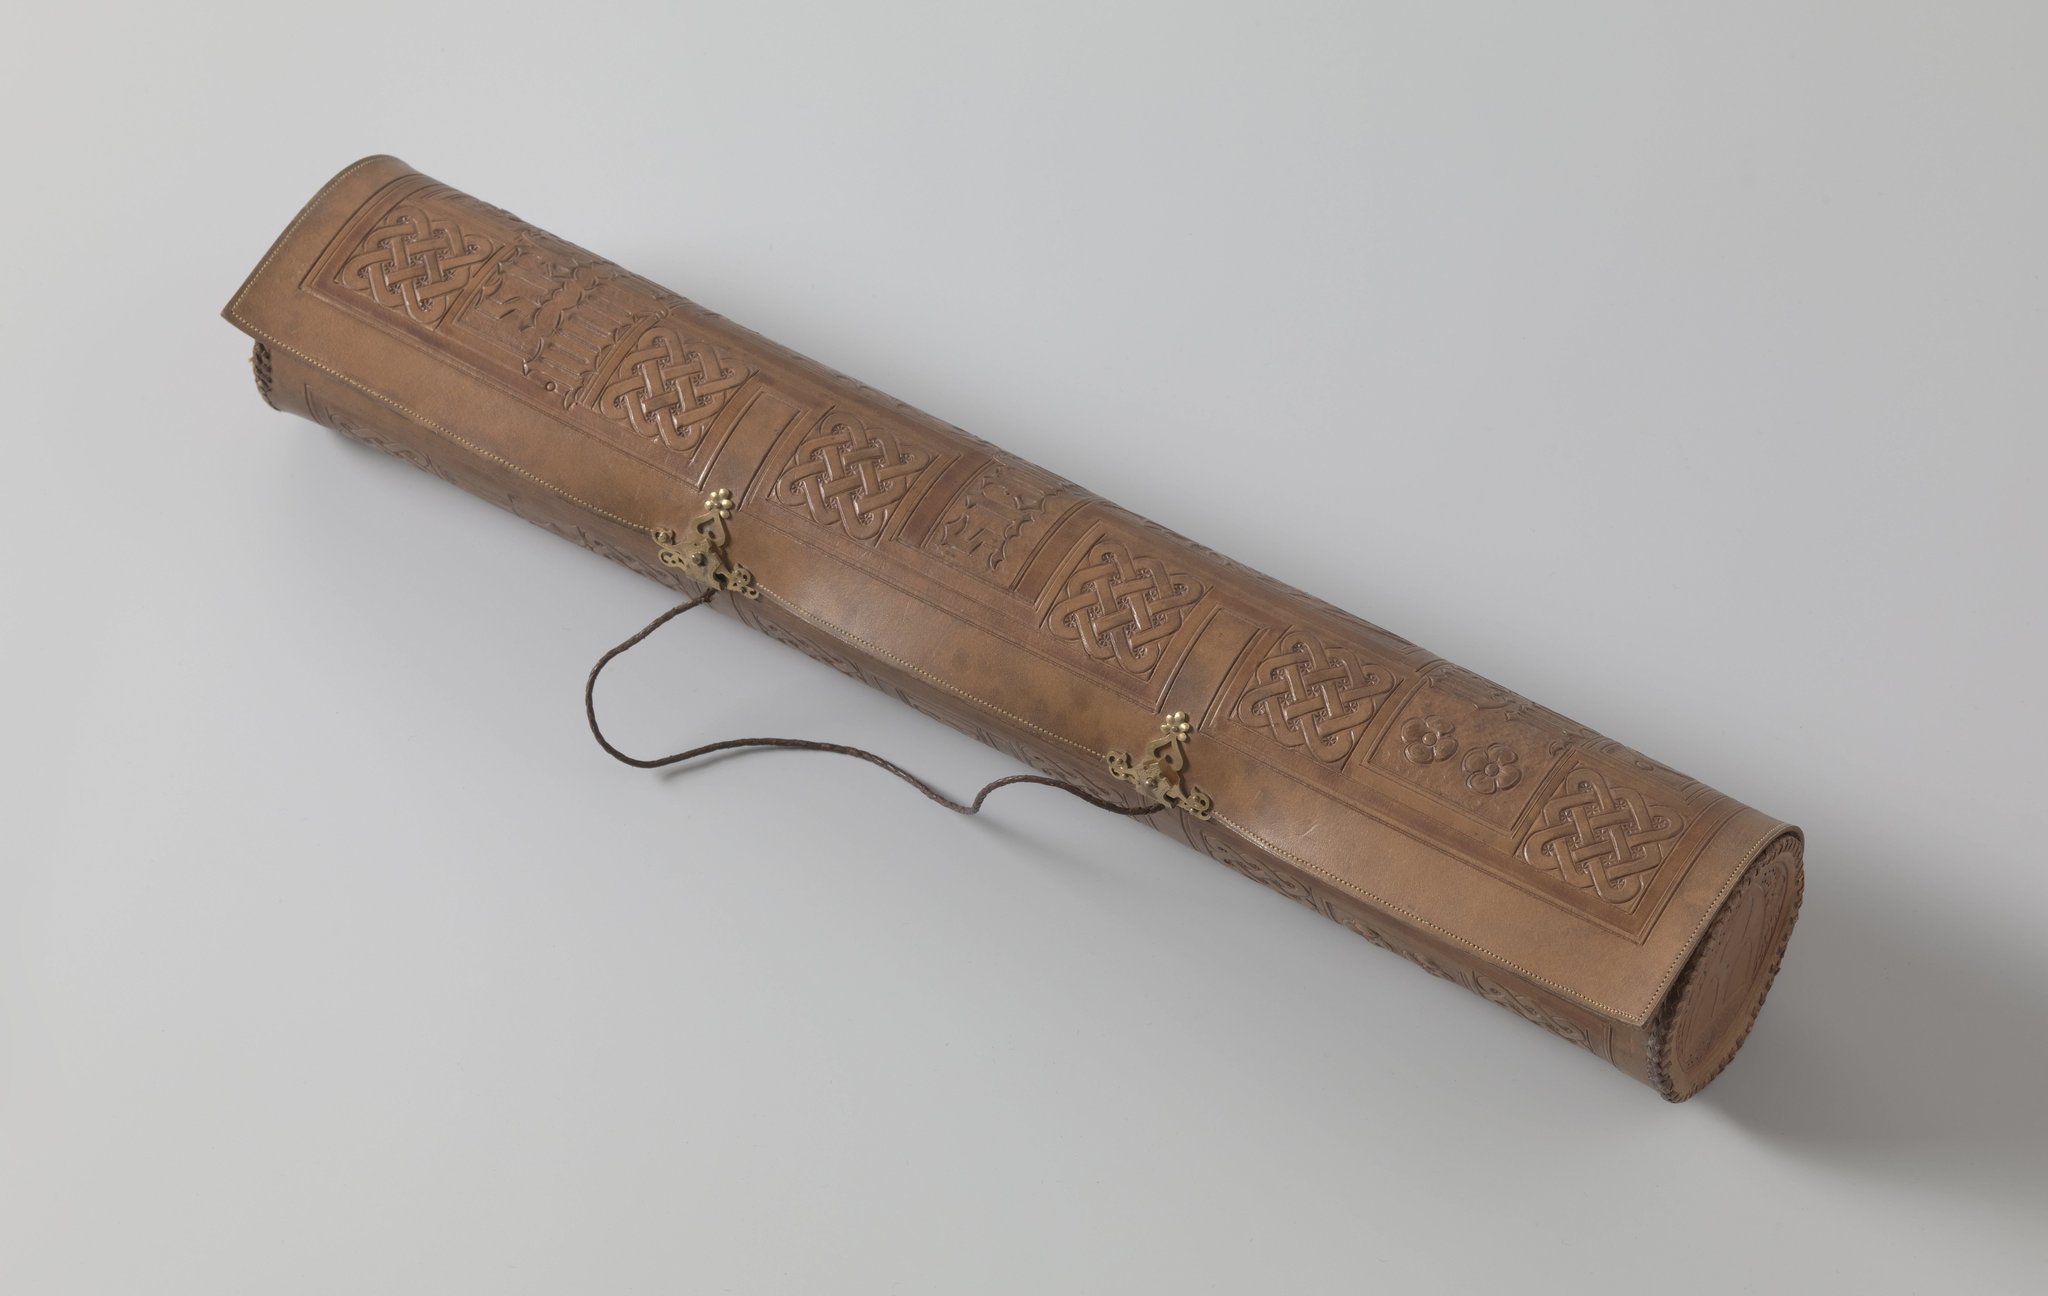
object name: case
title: Foedraal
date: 1894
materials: leather, metal, textile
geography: utrecht